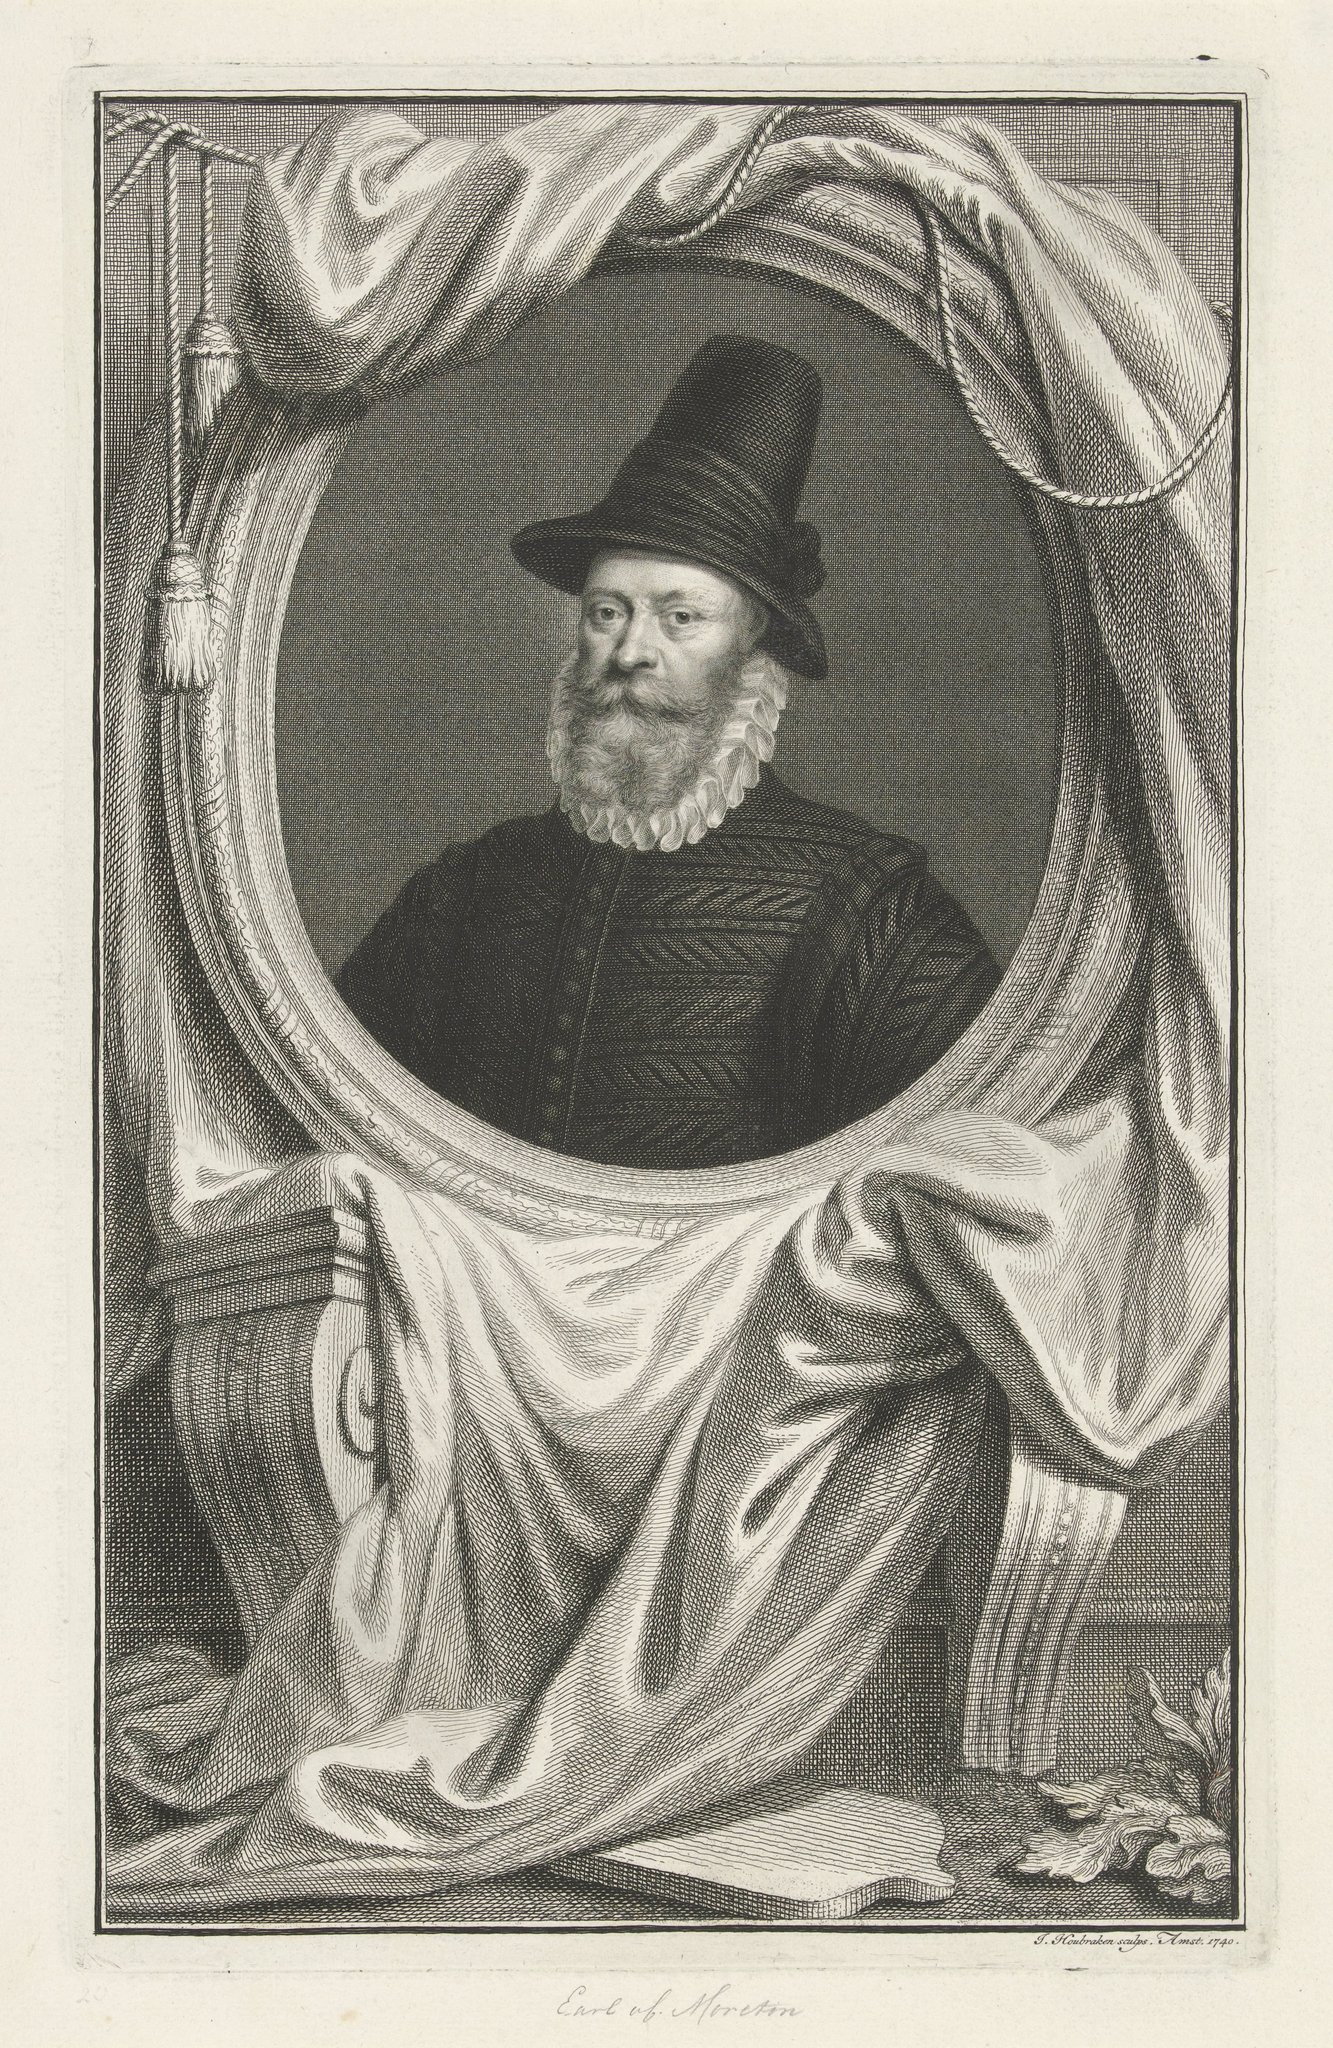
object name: print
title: Portret van James Douglas, 4e graaf van Morton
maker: jacob houbraken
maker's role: draughtsman, print maker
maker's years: 1698-1780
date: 1740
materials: paper, pencil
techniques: engraving, etching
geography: amsterdam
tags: soldaat, james douglas (4e graaf van morton)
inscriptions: collector's mark: Lugt 240, name: ‘Earl of Moreton’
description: Prent ook gebruikt in: Thomas Birch. The heads of illustrious persons of Great Britain : engraved by Houbraken, and Vertue, with their lives and characters. London: John en Paul Knapton, 1743-1751.